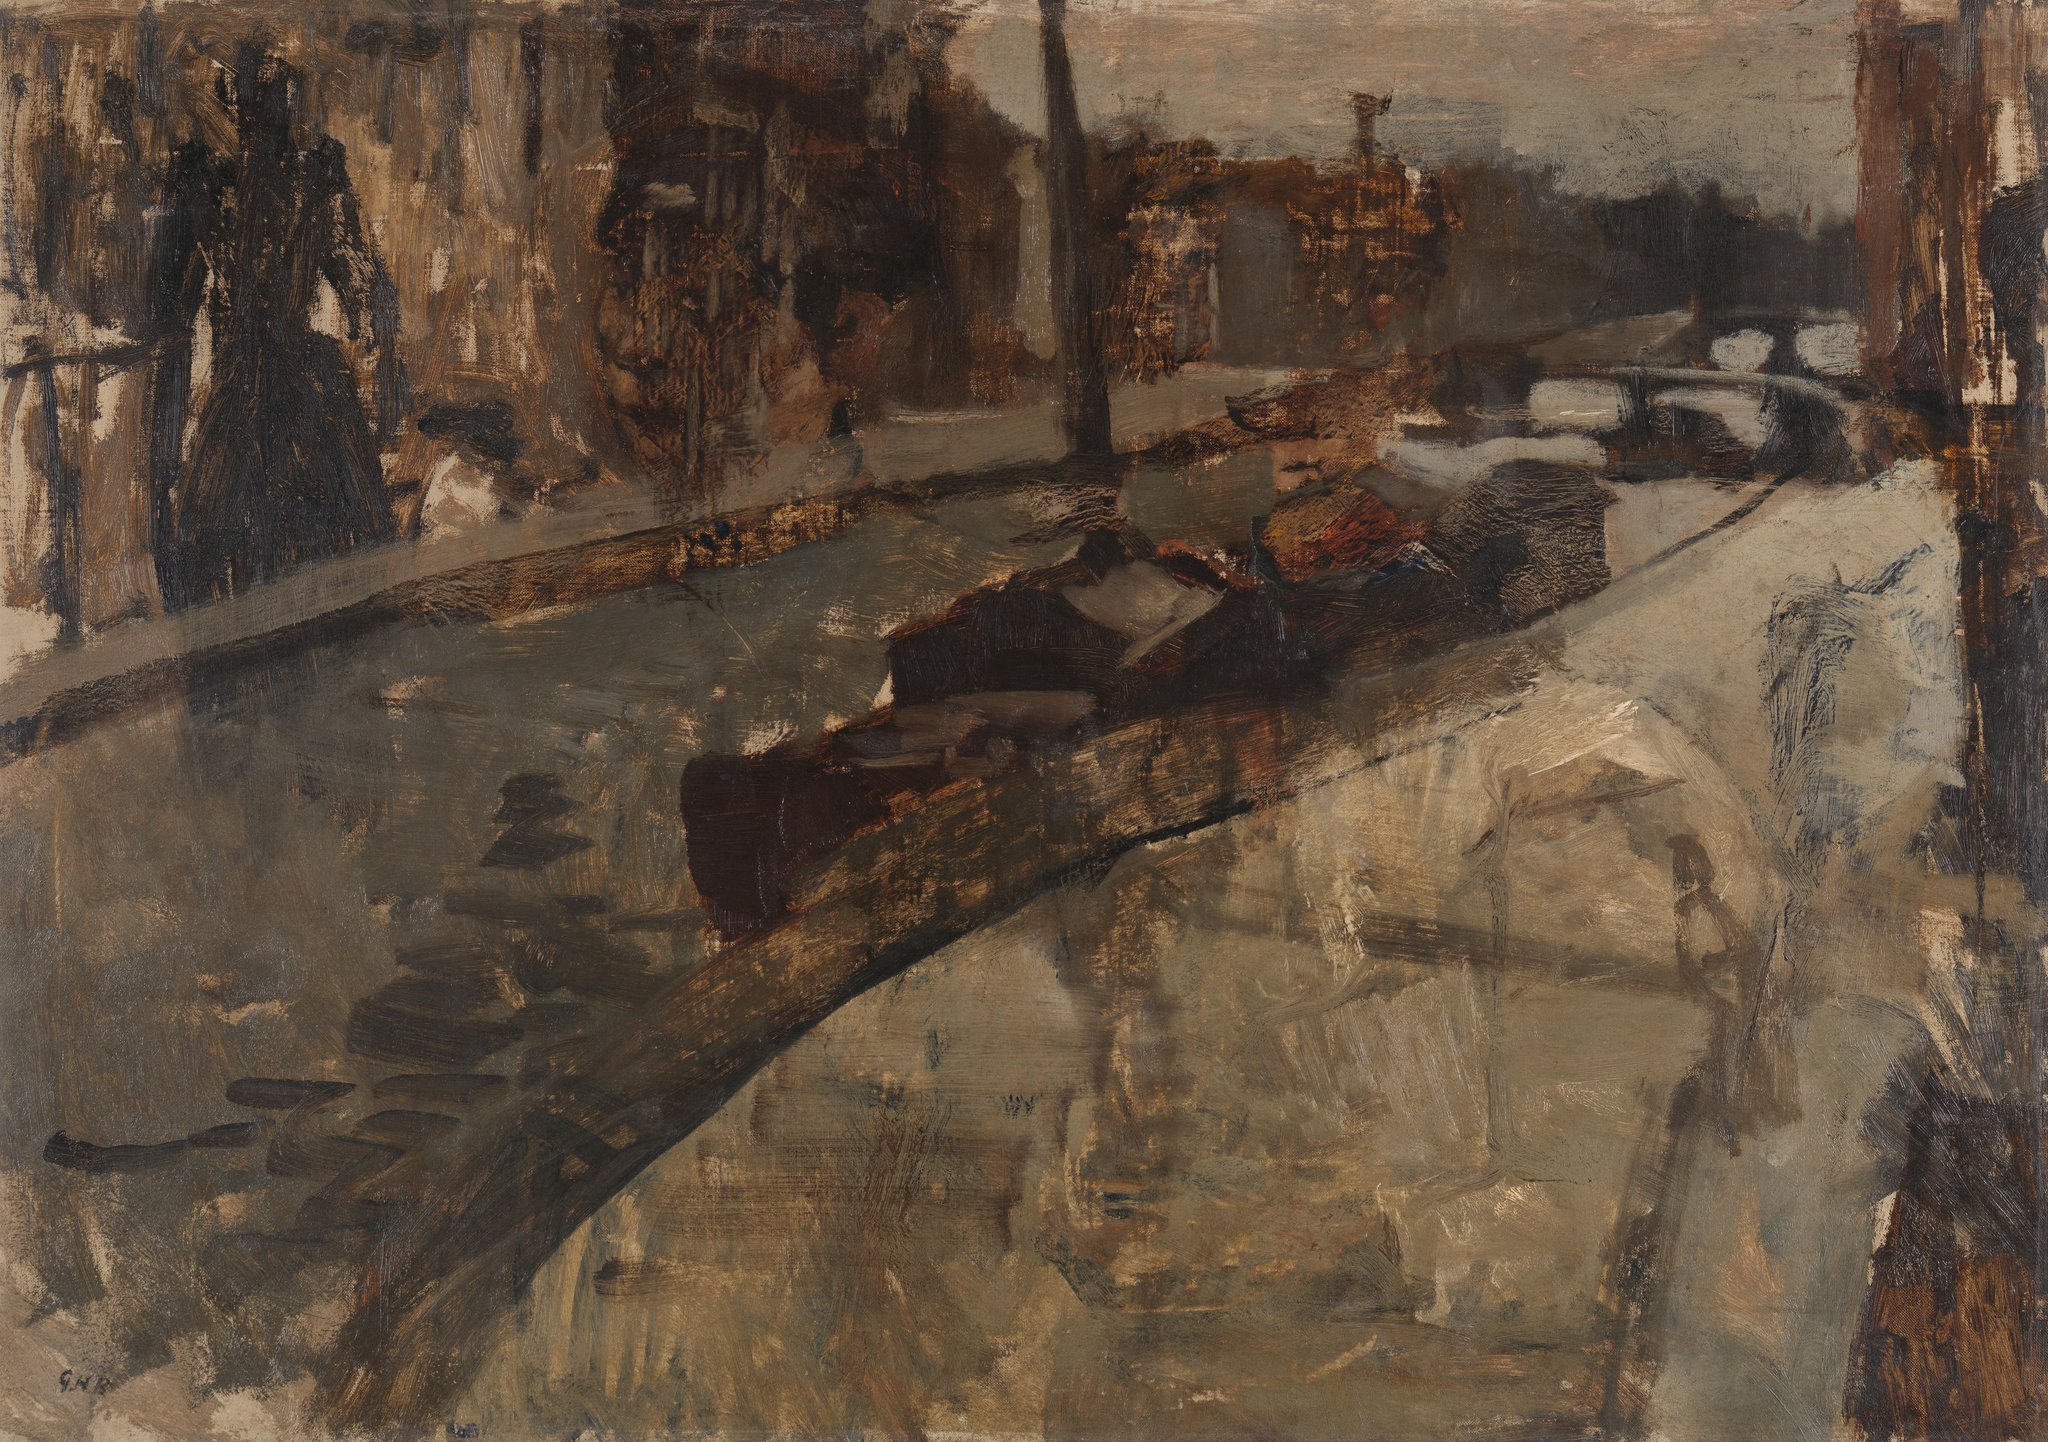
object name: painting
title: Prinsengracht near Lauriergracht, Amsterdam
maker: george hendrik breitner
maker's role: draughtsman, painter, print maker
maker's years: 1857-1923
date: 1880-1923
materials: canvas, oil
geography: amsterdam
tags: canals, waters (in city)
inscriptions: signature: ‘G.H.B.’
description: Amsterdamse gracht. Studie van de Prinsengracht met enkele schepen. Onder deze studie resten van een schets met figuren.